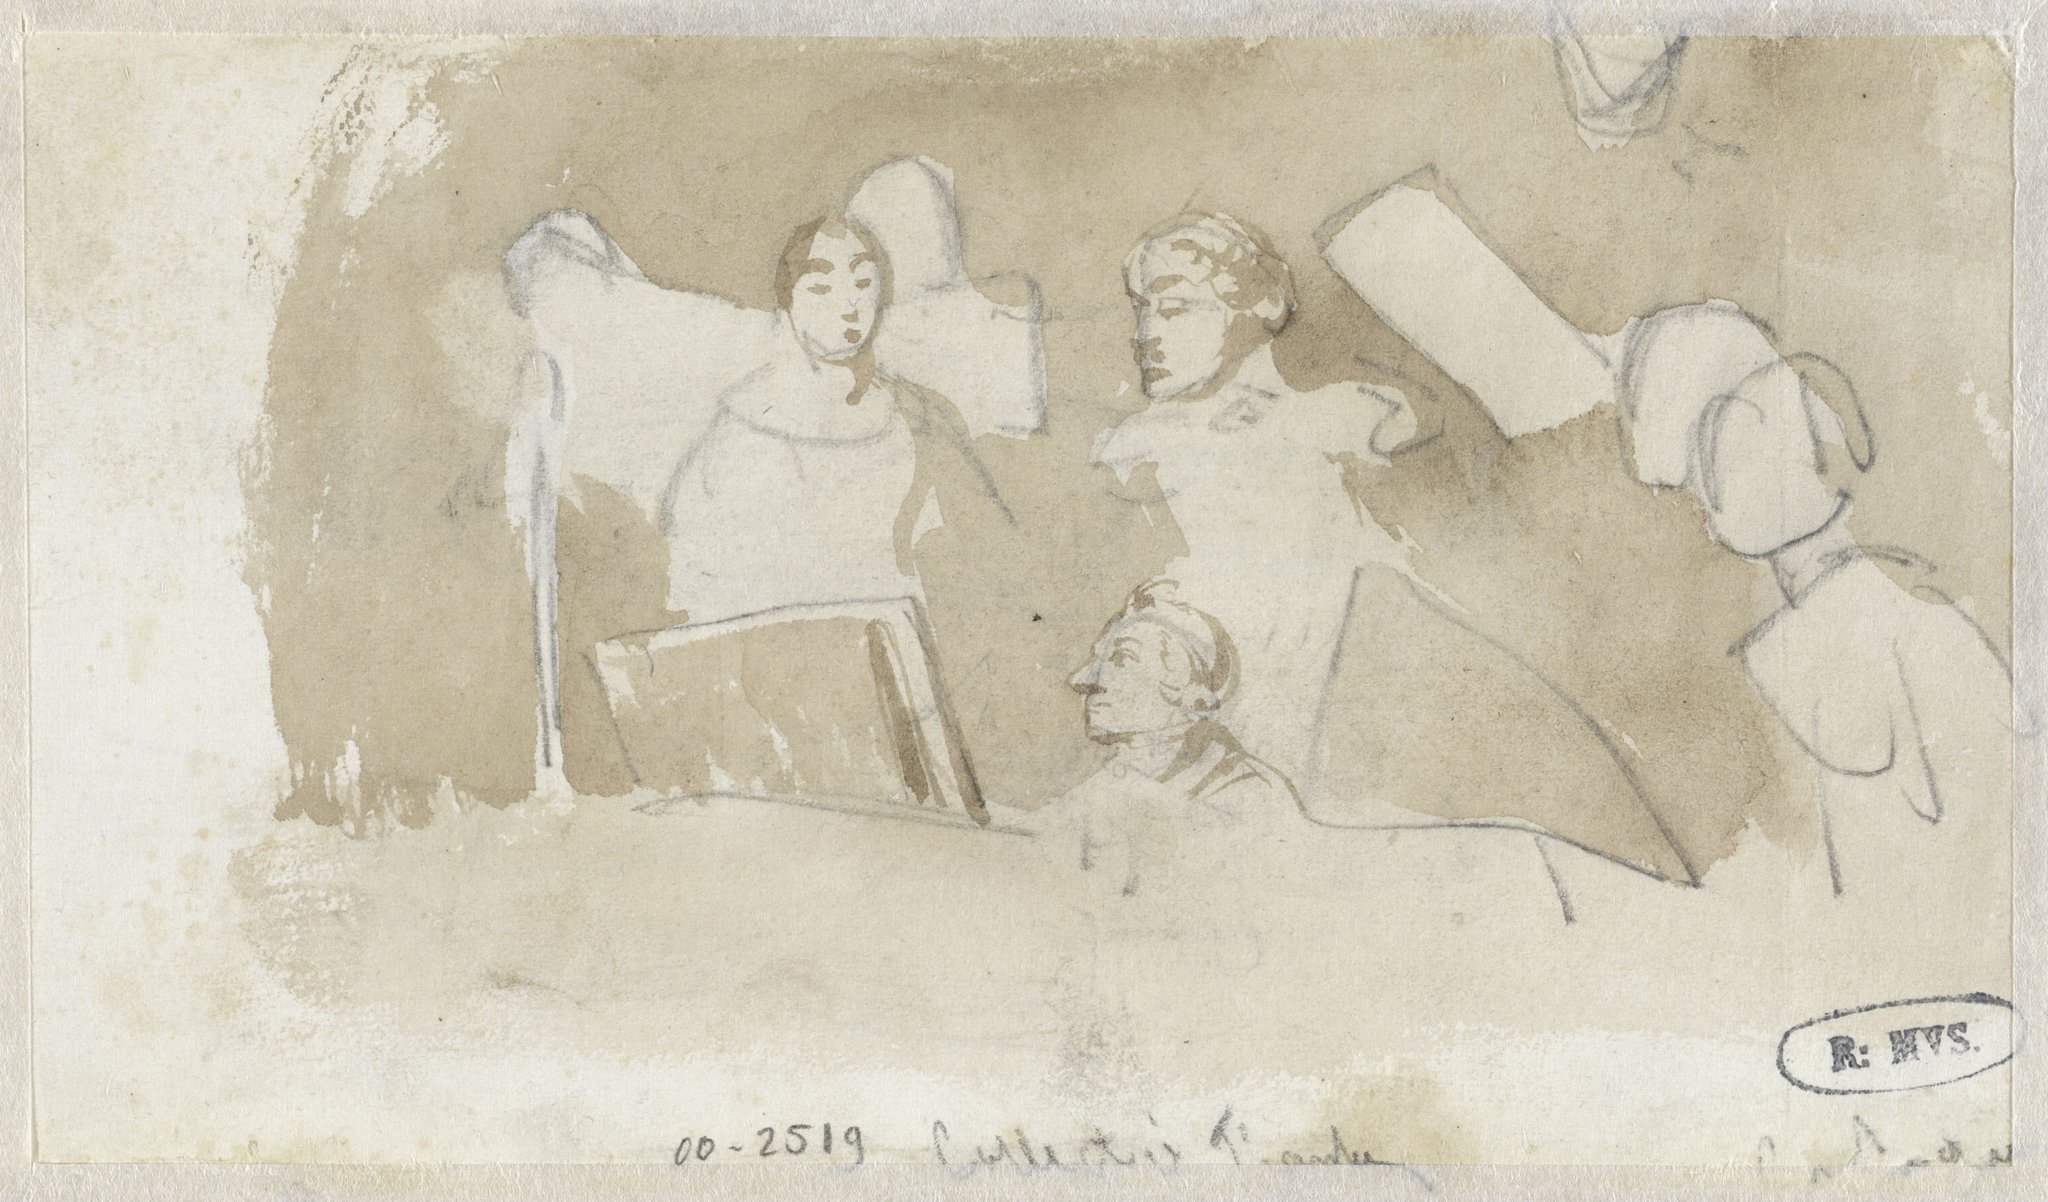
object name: drawing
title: Schets van groep zingende mensen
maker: charles rochussen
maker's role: draughtsman, painter, print maker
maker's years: 1814-1894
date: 1824-1894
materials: paper, pencil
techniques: brush